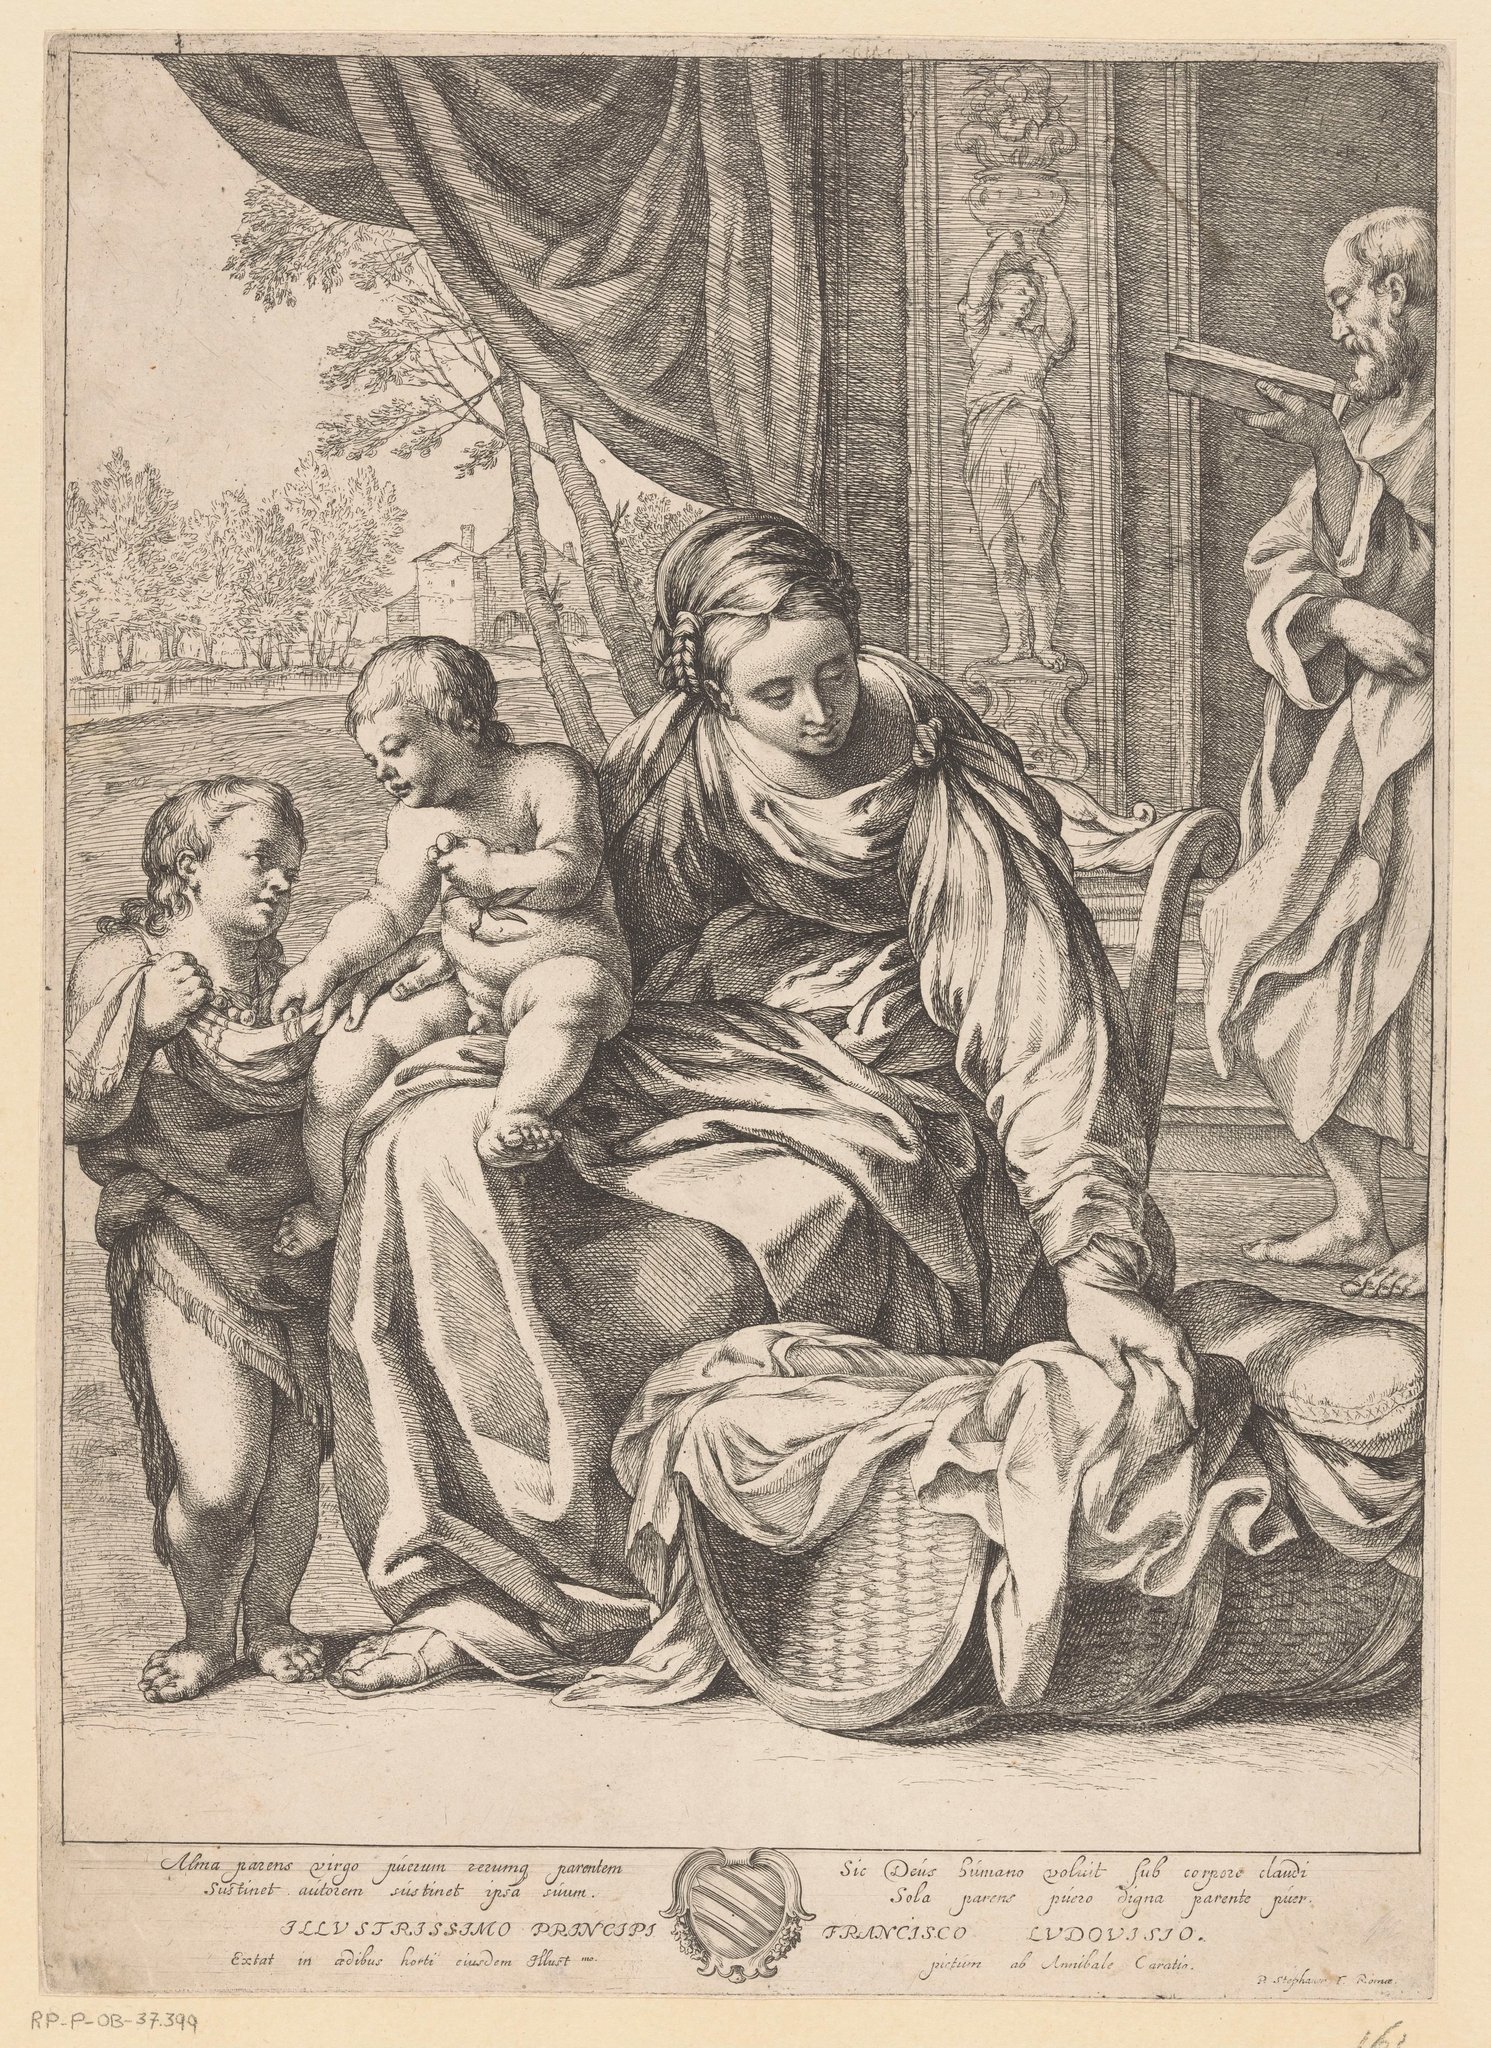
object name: print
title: Heilige Familie met Johannes de Doper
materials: paper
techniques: etching, intaglio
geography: italy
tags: holy family with john the baptist (as child), cradle, crib, fruits: cherry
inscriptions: collector's mark: Lugt 240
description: Maria zittend met het Christuskind op schoot en naast haar een wieg. Links staat de jonge Johannes de Doper met een doek gevuld met kersen. Rechts staat Jozef met een boek. Opdracht en twee kolommen Latijnse tekst.